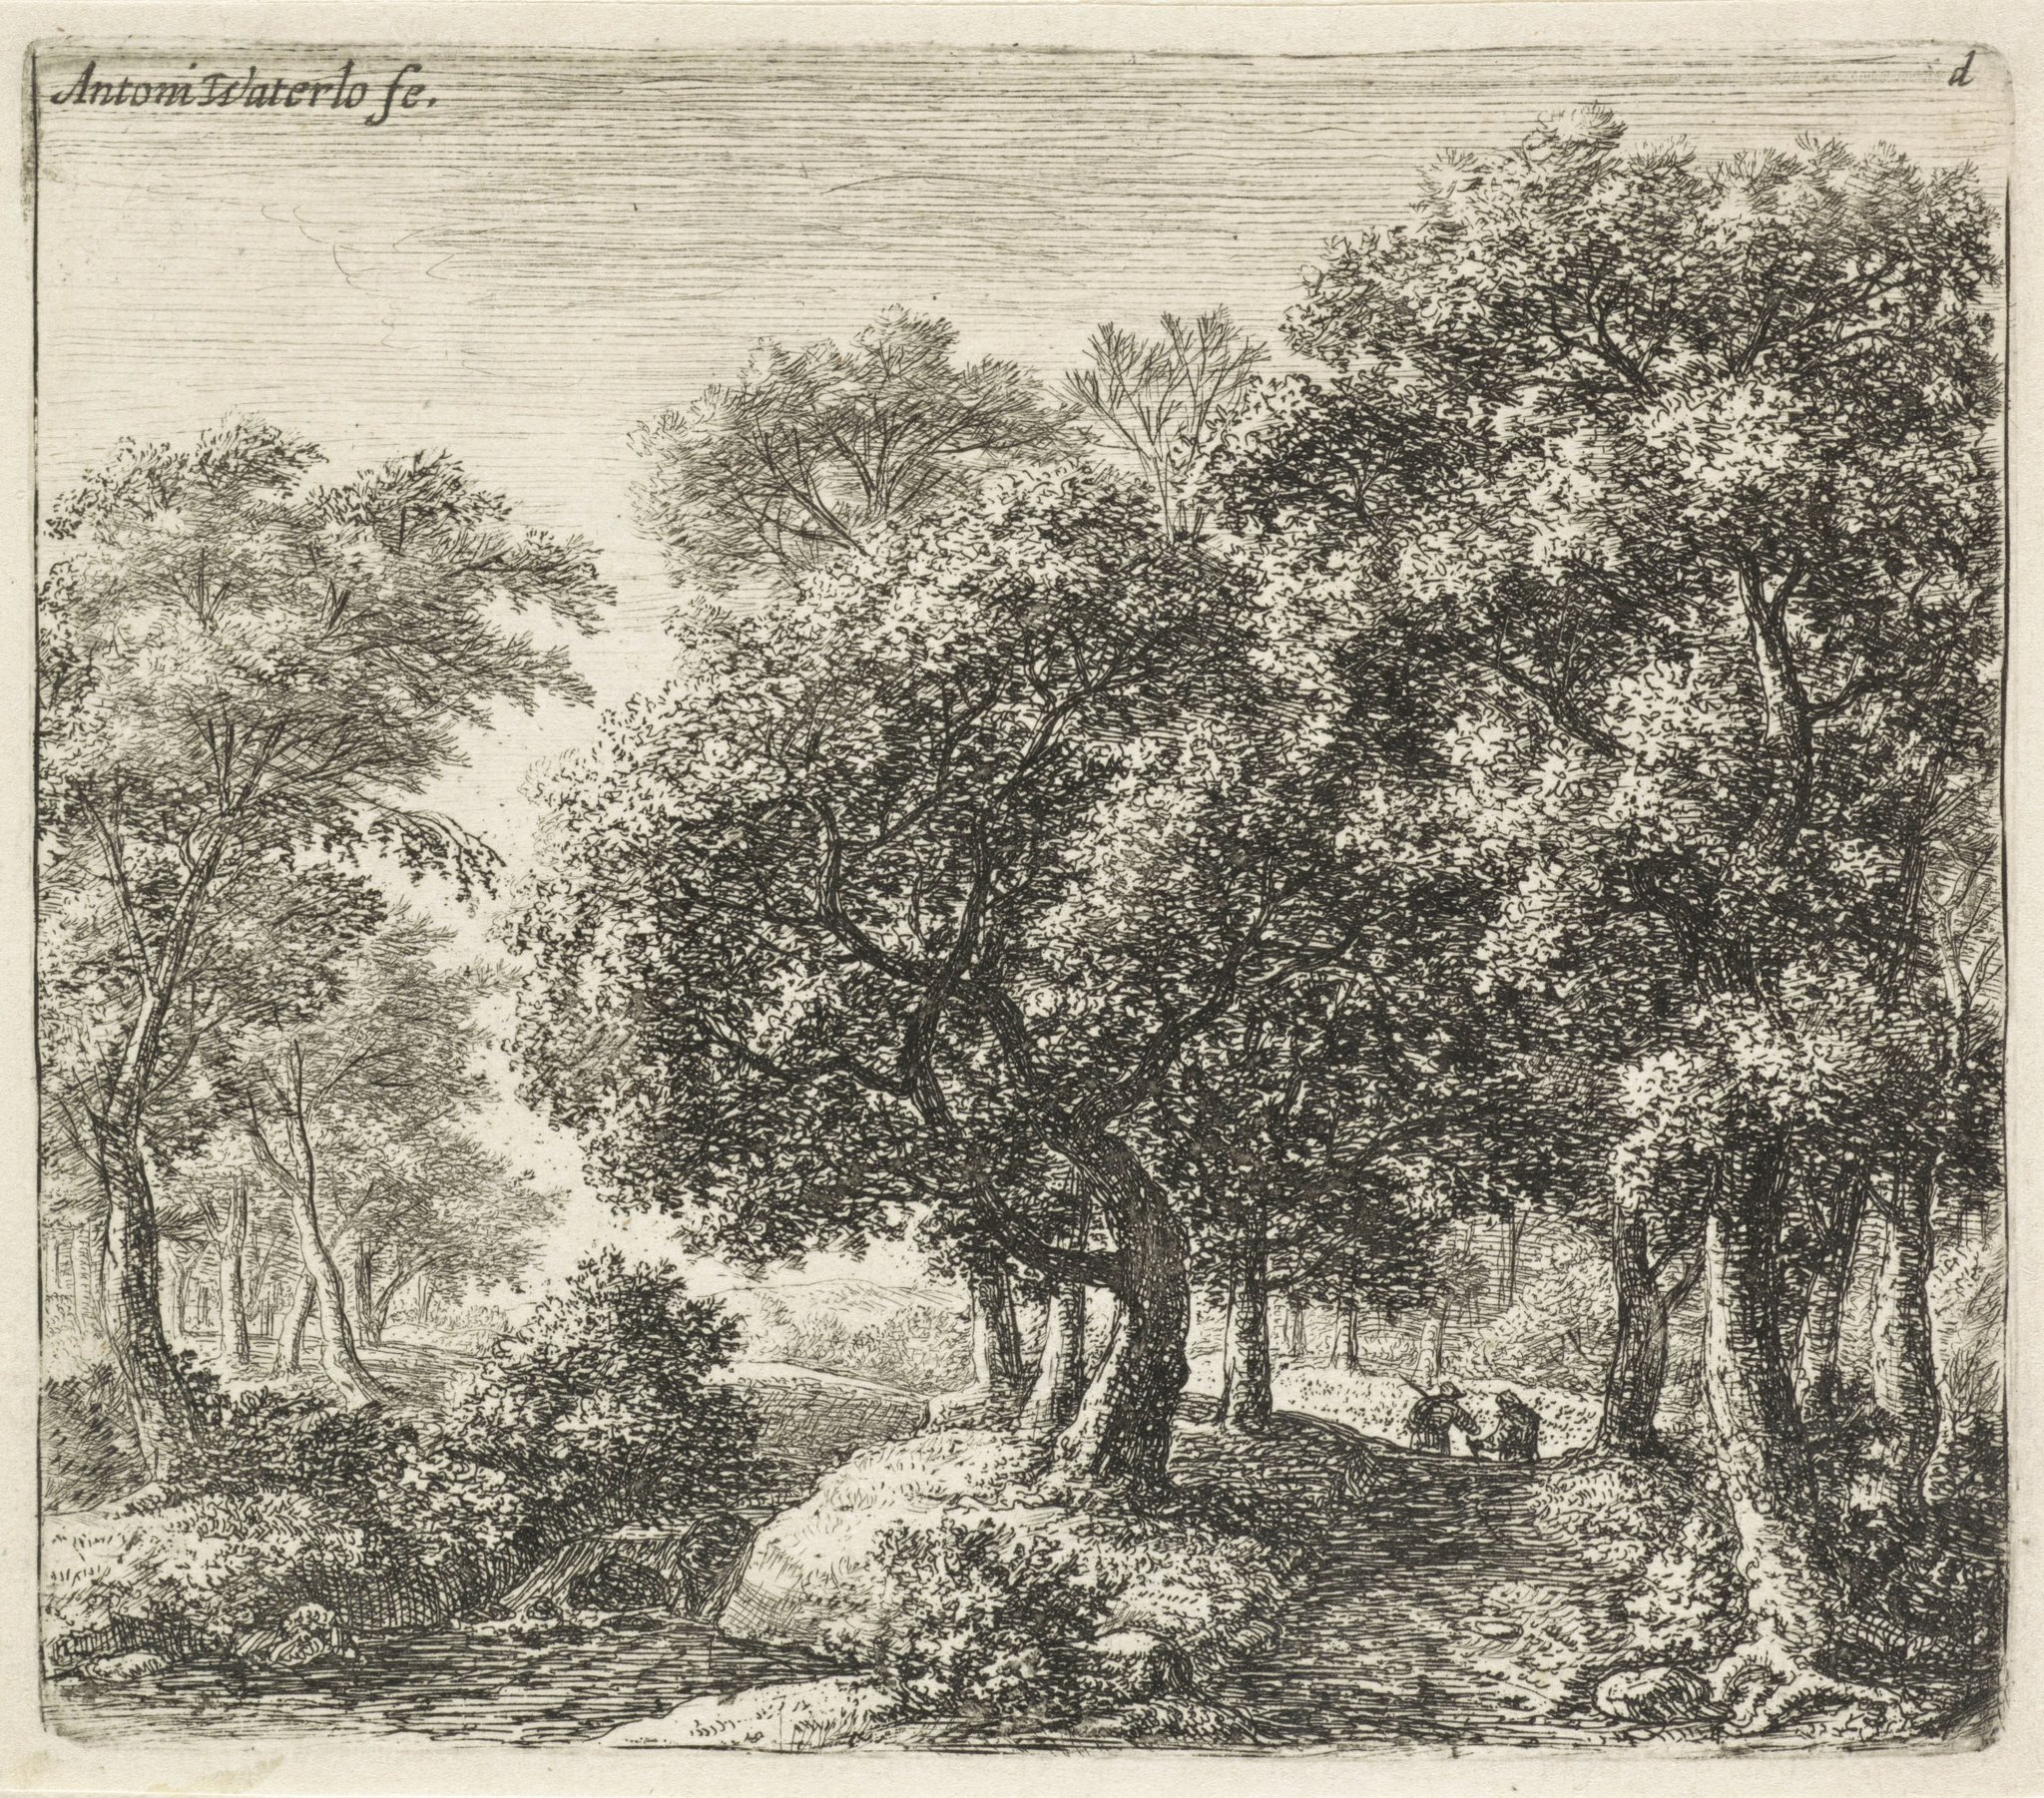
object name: print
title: Twee figuren op een bospad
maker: anthonie waterloo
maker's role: draughtsman, painter, print maker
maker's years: 1609-1690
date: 1630-1663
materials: paper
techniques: etching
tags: brook, forest path or lane, landscapes (+ landscape with figures, staffage)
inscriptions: collector's mark: Lugt 2228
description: Rechts lopen twee figuren op een bospad. Links stroomt een beek. Rechtsboven is de letter d weergegeven.